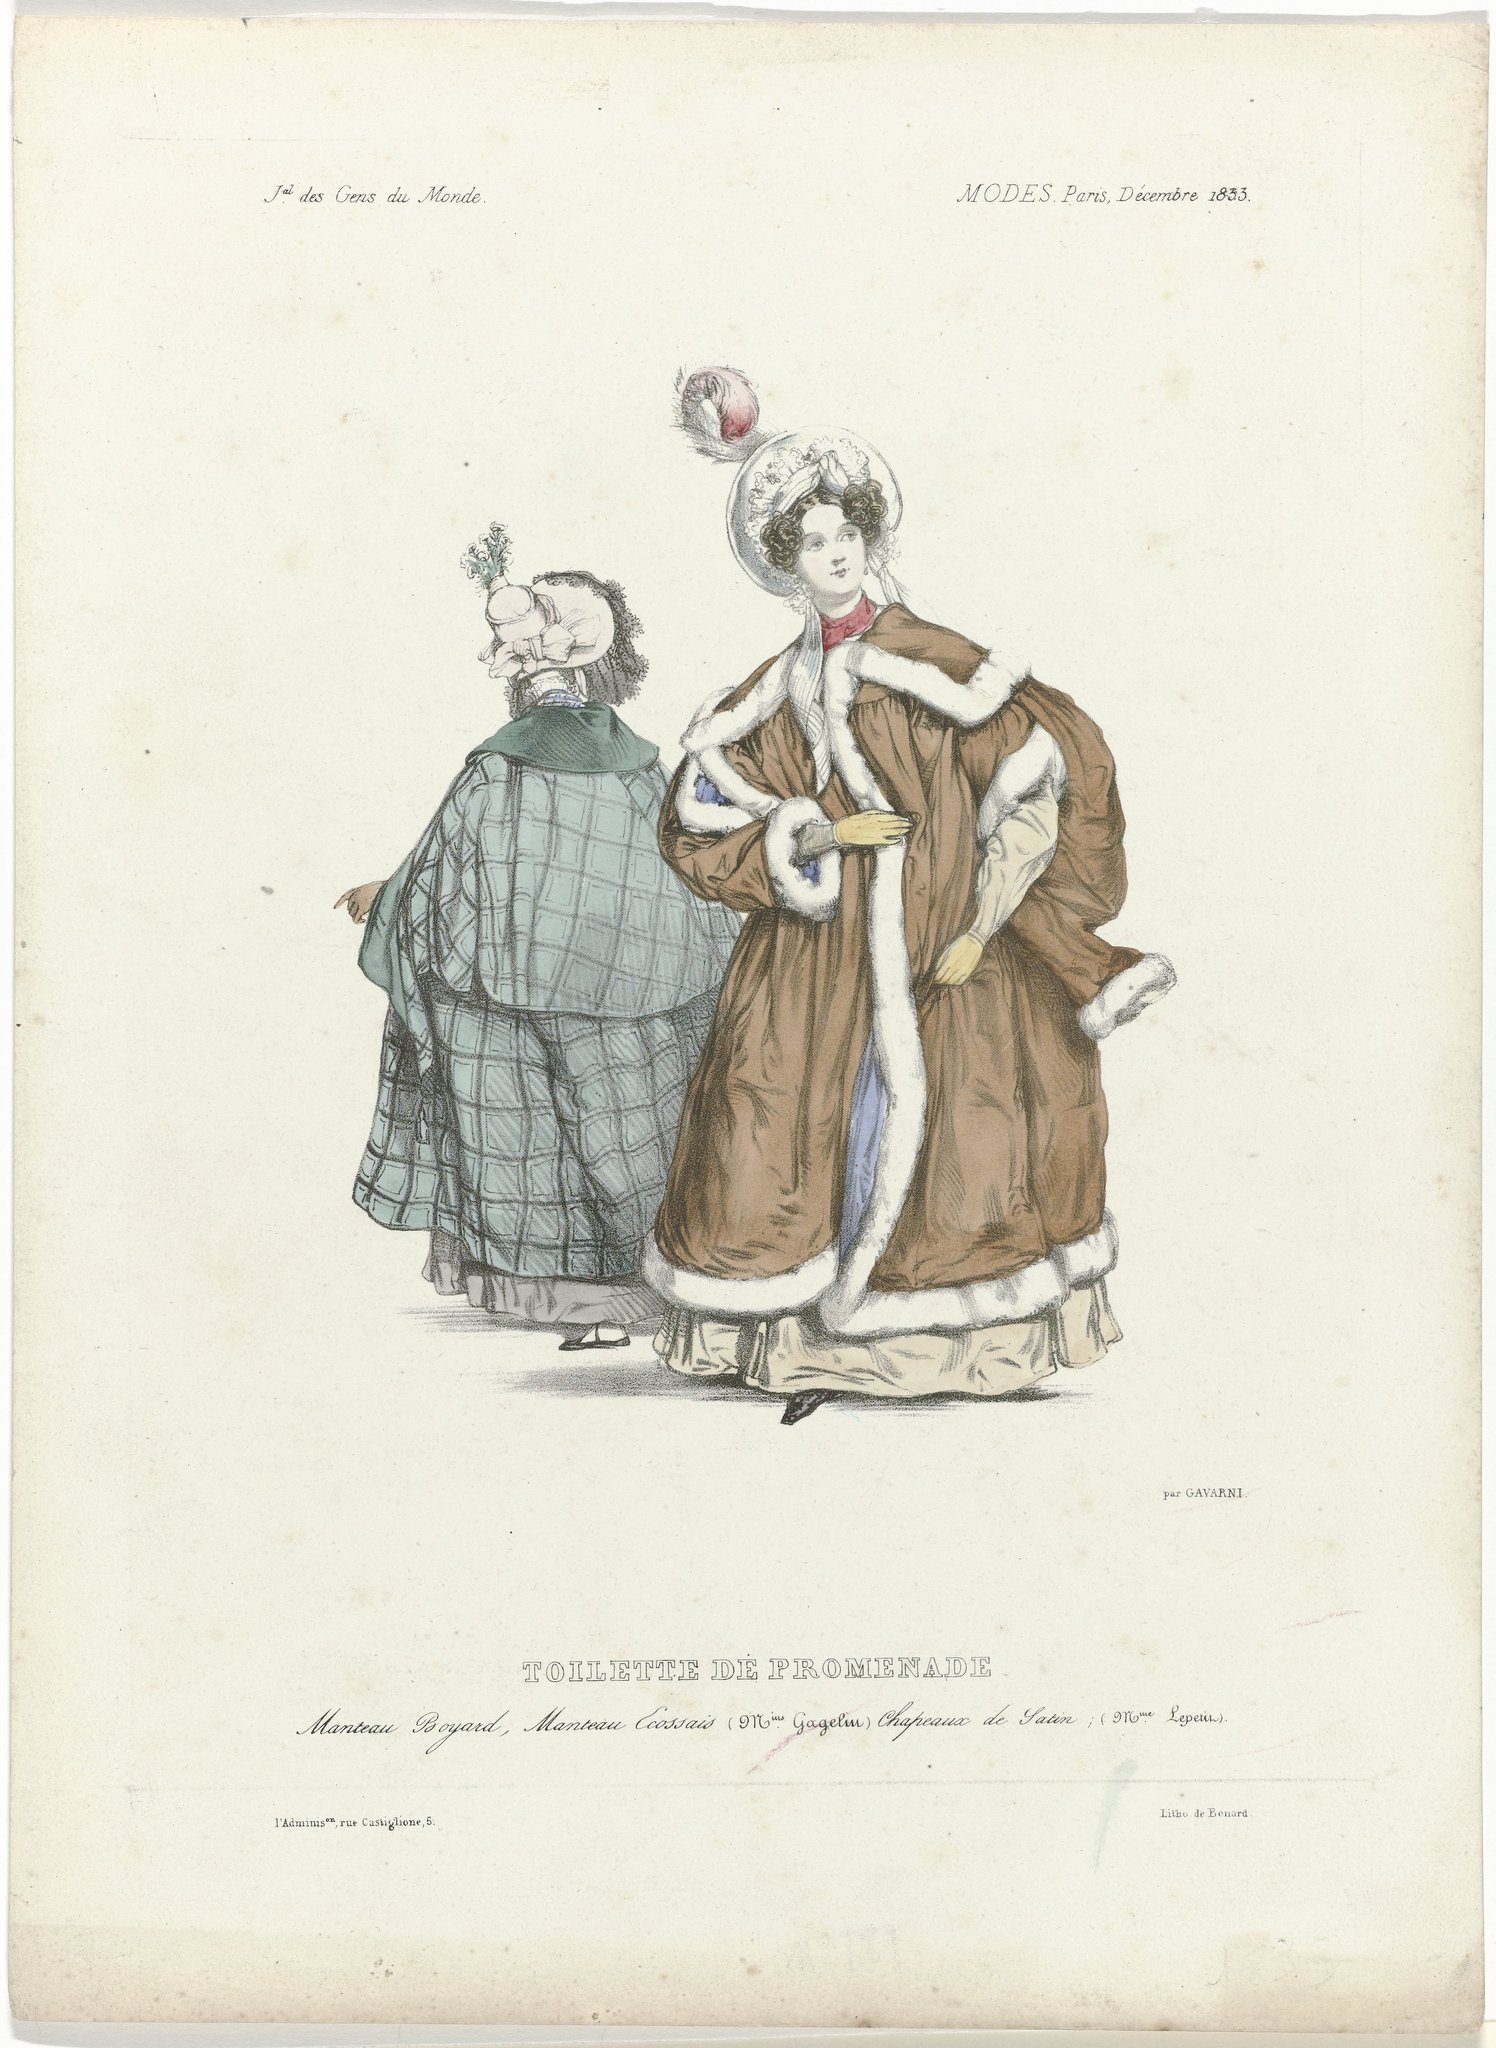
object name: fashion print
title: Journal des Gens du Monde, Modes Paris, décembre 1833 : Toilette de Promenad (...)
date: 1833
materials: paper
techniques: hand coloring, lithograph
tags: dress, gown: walking dress (+ women's clothes), border, ribbon, braid (+ fur used for clothes), coat (+ women's clothes), fashion plates, head-gear: hat (+ women's clothes), gloves, mittens, etc. (+ women's clothes), neck-gear ~ clothing (+ women's clothes)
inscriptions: caption: ‘Toilette de promenade / Manteau Boyard, manteau Ecossais (M.ins Gagelin). Chapeaux de Satin; (M.me Lepetit)’, address: ‘L'Adminison, rue Castiglione, 5.’, title: ‘J.al des Gens du Monde. / Modes. Paris, Décembre 1833.’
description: 'Toilette de promenade ' of wandelkostuum. 'Manteau Boyard' en een geruite mantel uit de winkels van Gagelin. Hoeden van satijn van Lepetit. Prent uit het modetijdschrift Journal des Gens du Monde (6 december 1833- mei 1834).